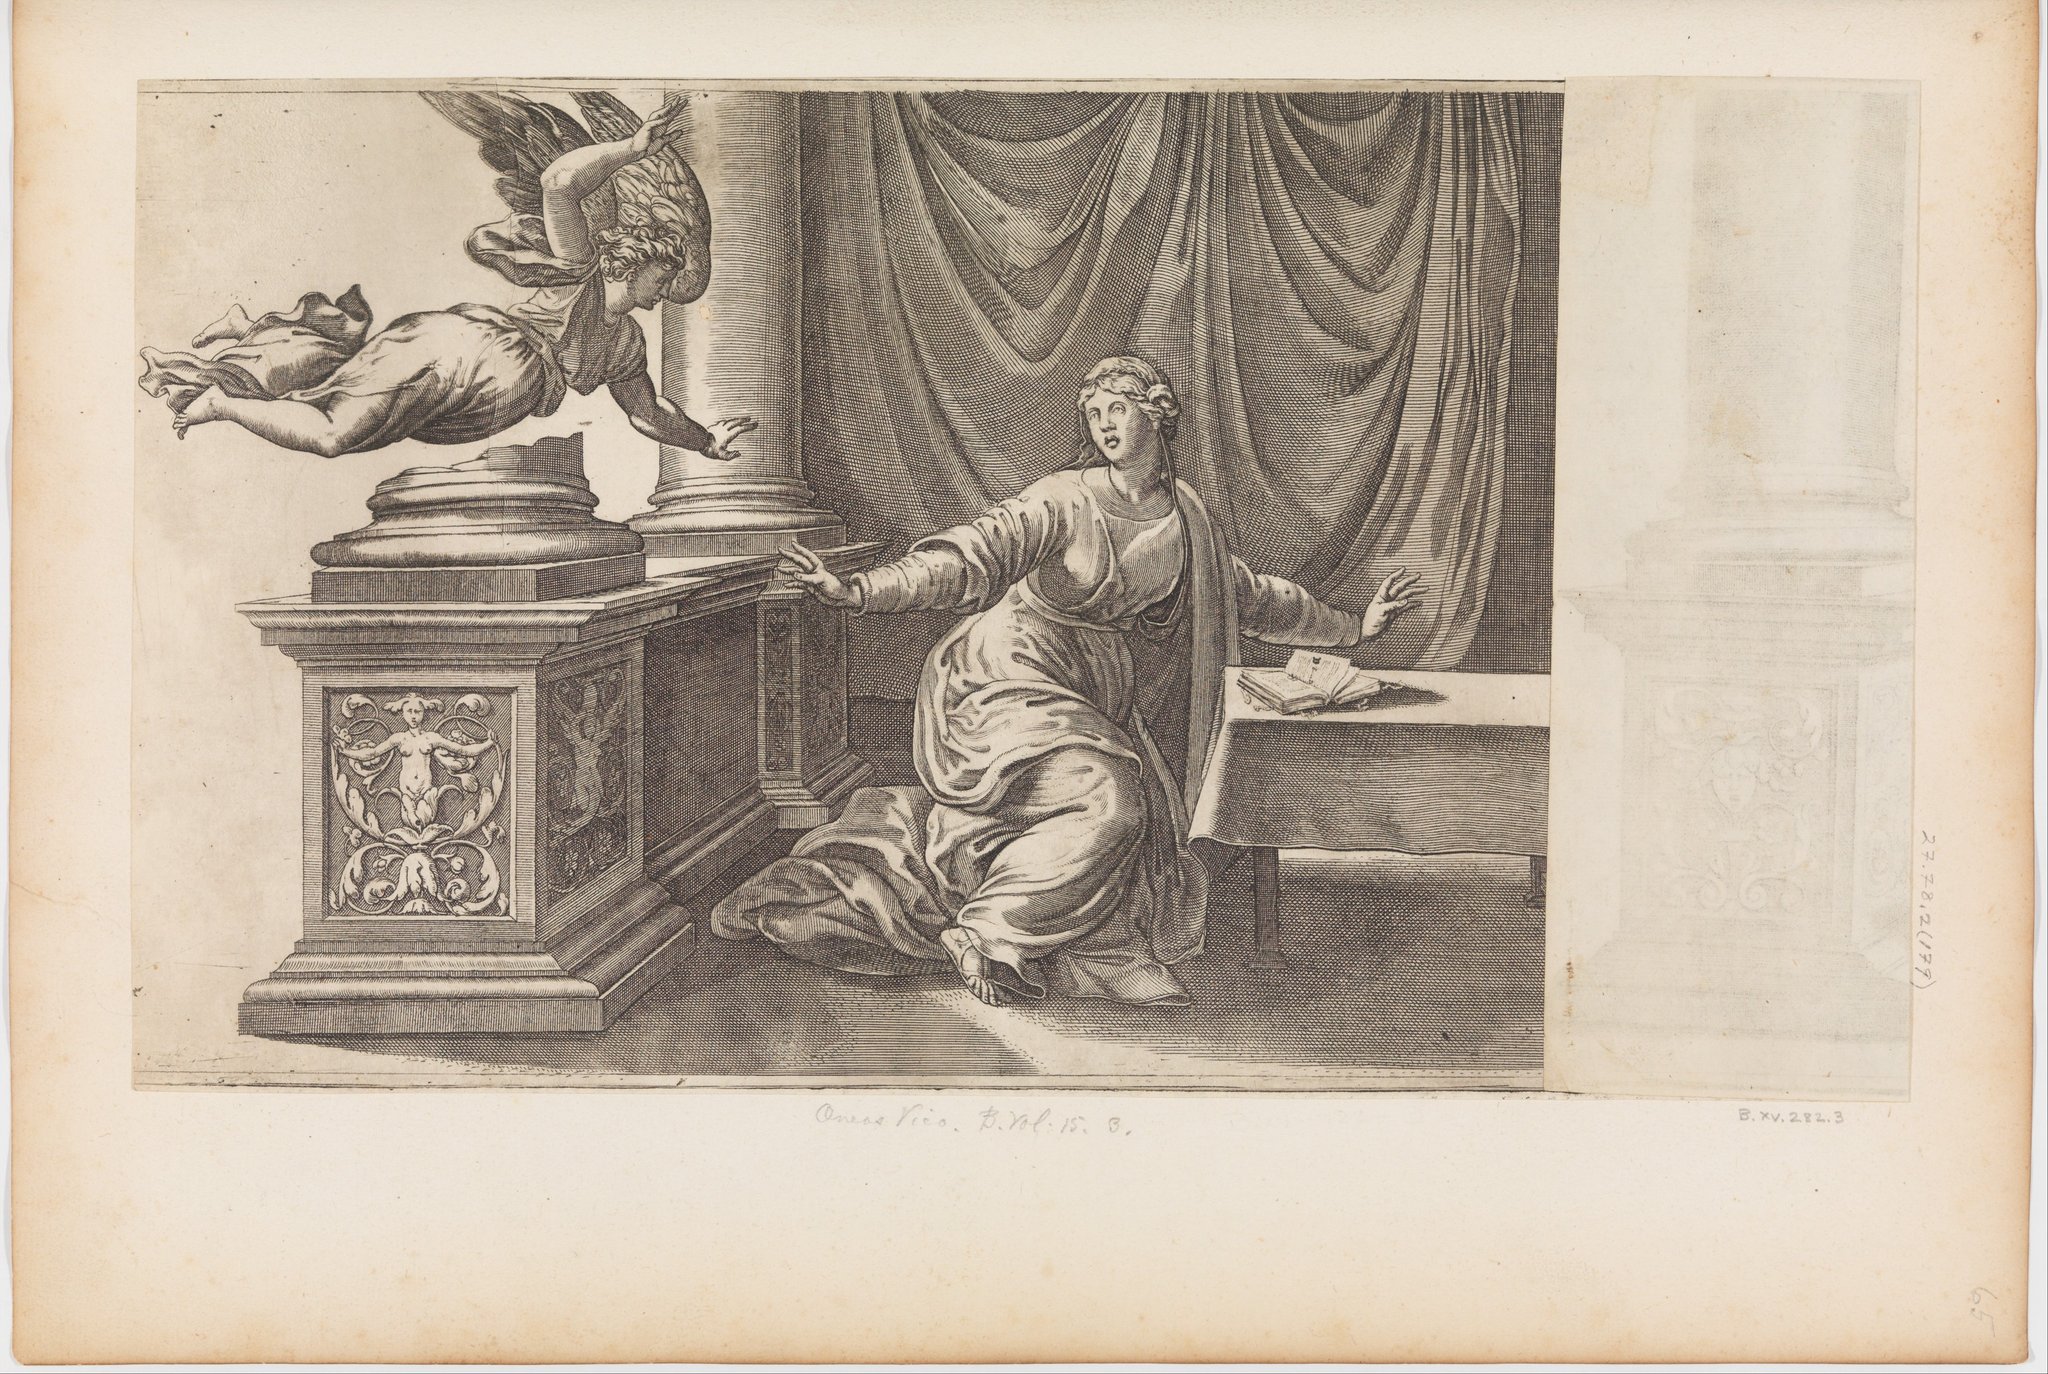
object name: print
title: The Annunciation with Flying Angel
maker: enea vico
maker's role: artist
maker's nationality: italian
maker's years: 1523-1567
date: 1548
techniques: engraving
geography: venice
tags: angels,virgin mary,annunciation